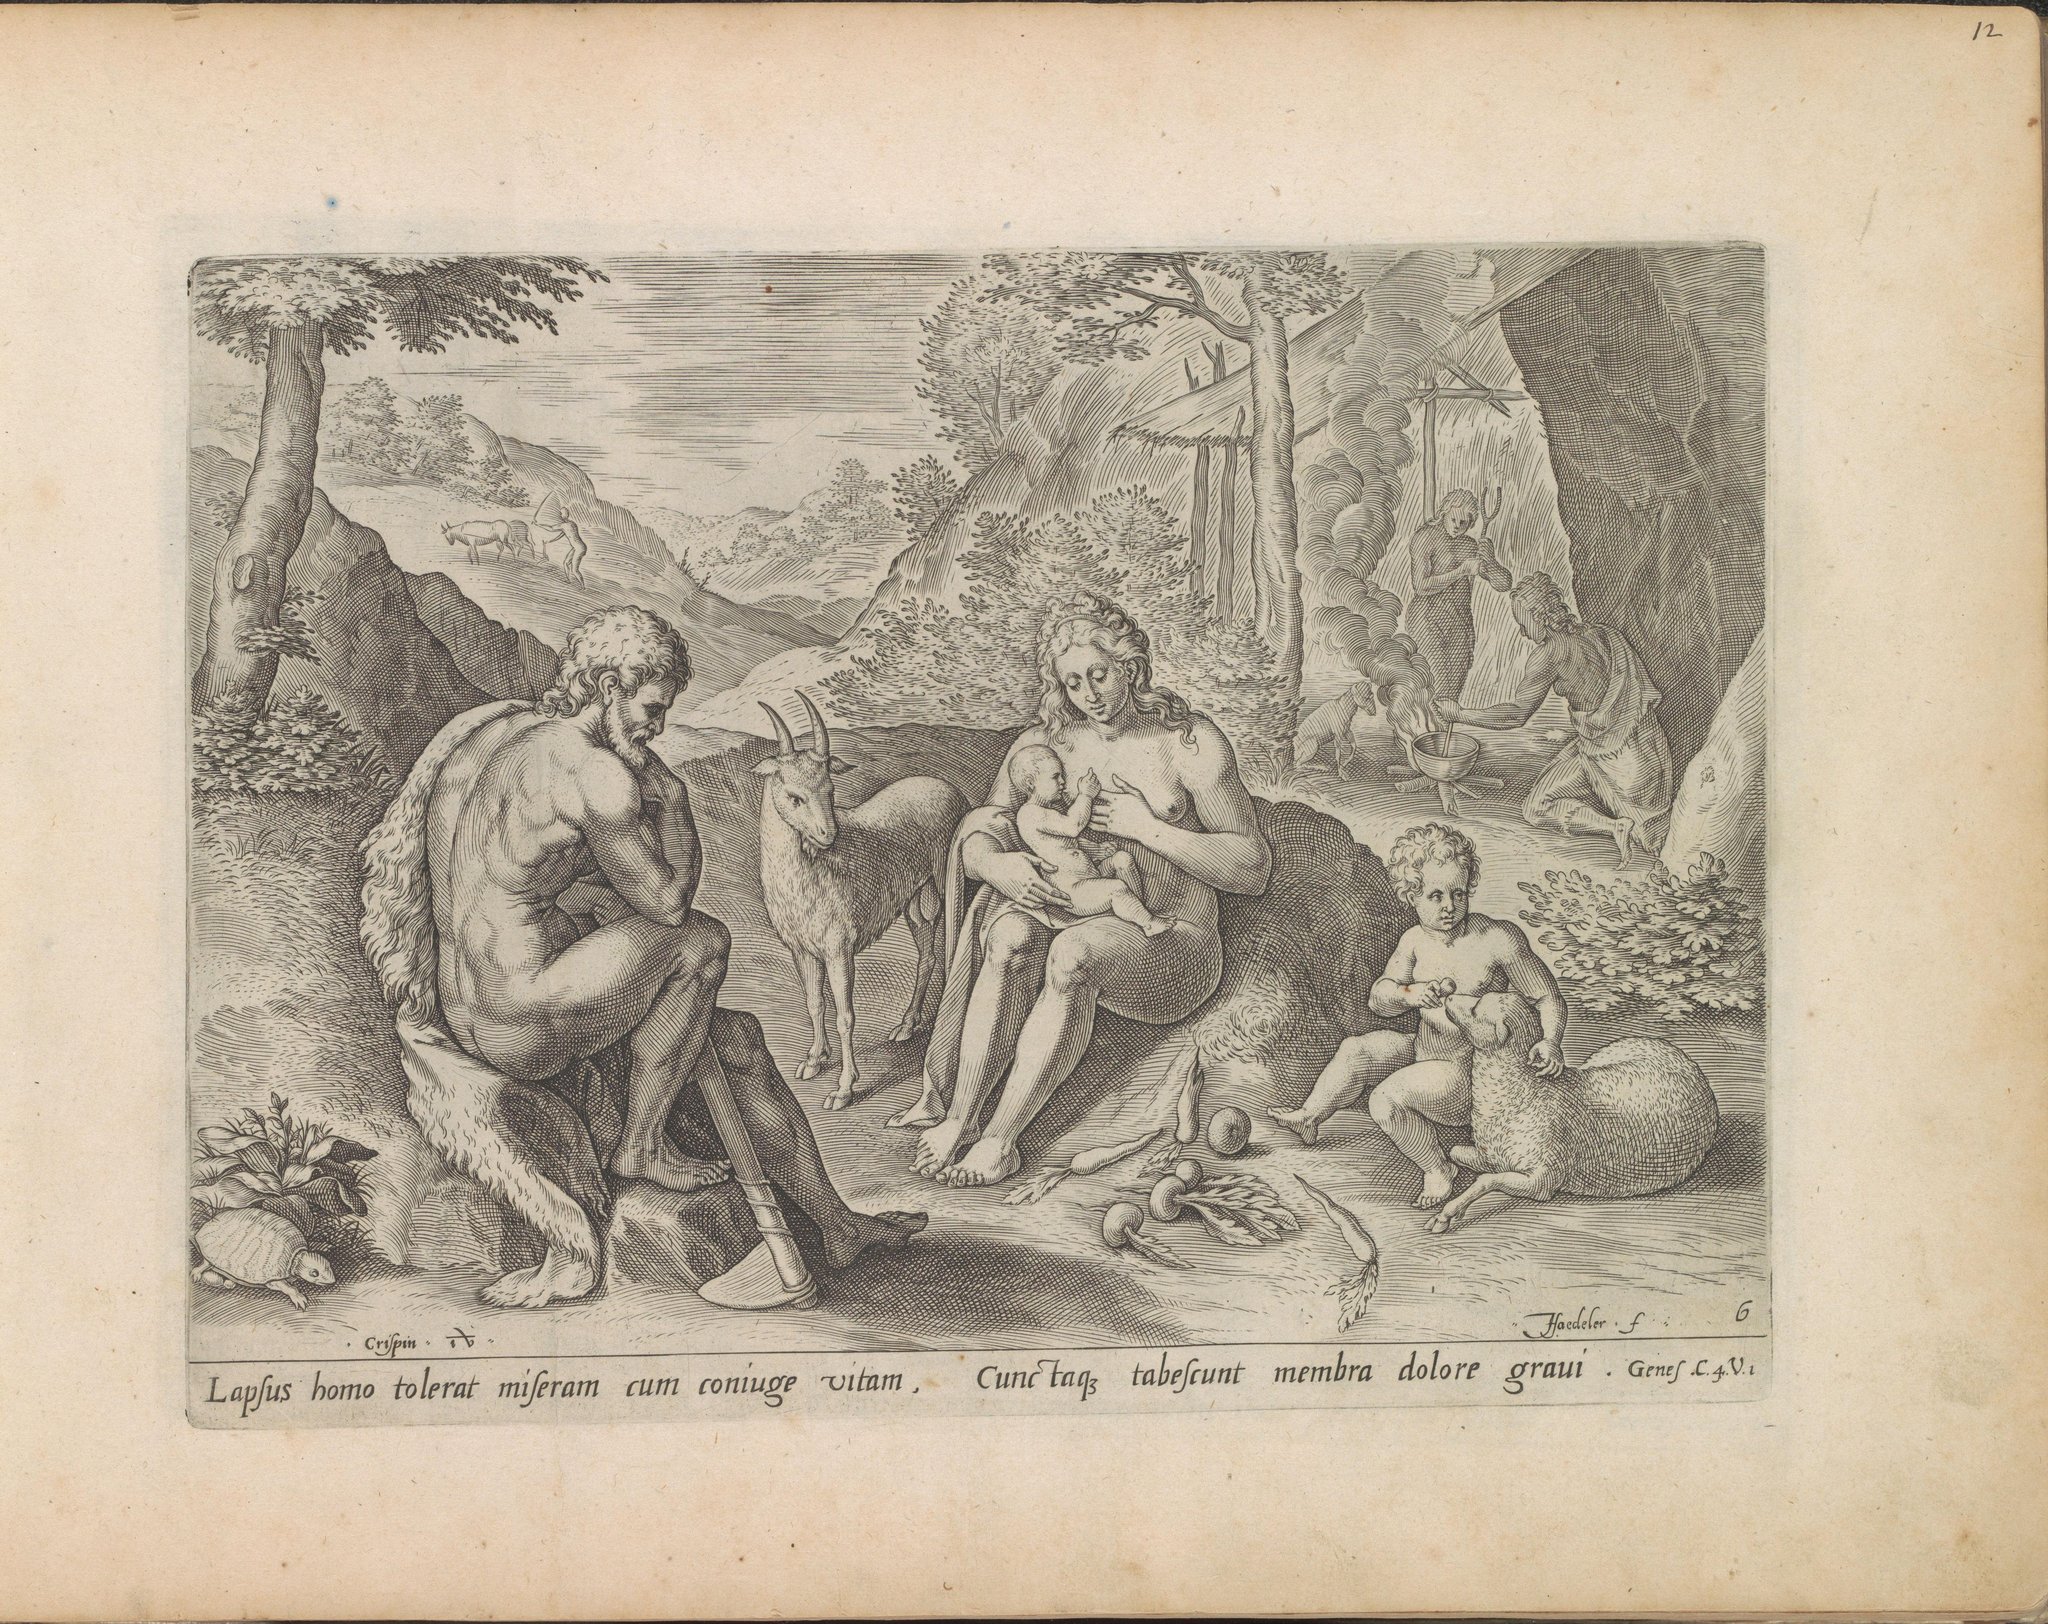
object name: album leaf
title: Theatrum Biblicum Hoc Est Historiae Sacrae Veteris et Novi Testamenti Tabulis Aeneis Expressae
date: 1643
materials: paper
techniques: engraving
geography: amsterdam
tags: adam engaged in agricultural activities, eve suckling the children, the labours of adam and eve; infancy of cain and abel (genesis 4:1-2)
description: Adam en Eva en hun kinderen Kaïn en Abel in de wildernis buiten het paradijs. Adam rust van het werk dat hij dagelijks moet verrichten. Eva geeft Abel de borst. Kaïn geeft een schaap te eten. Rechts Adam en Eva kokend voor hun huis. Op de achtergrond bewerkt Adam het land. Onderaan een verwijzing naar de Bijbeltekst in het Latijn. Deze prent maakt deel uit van een album.